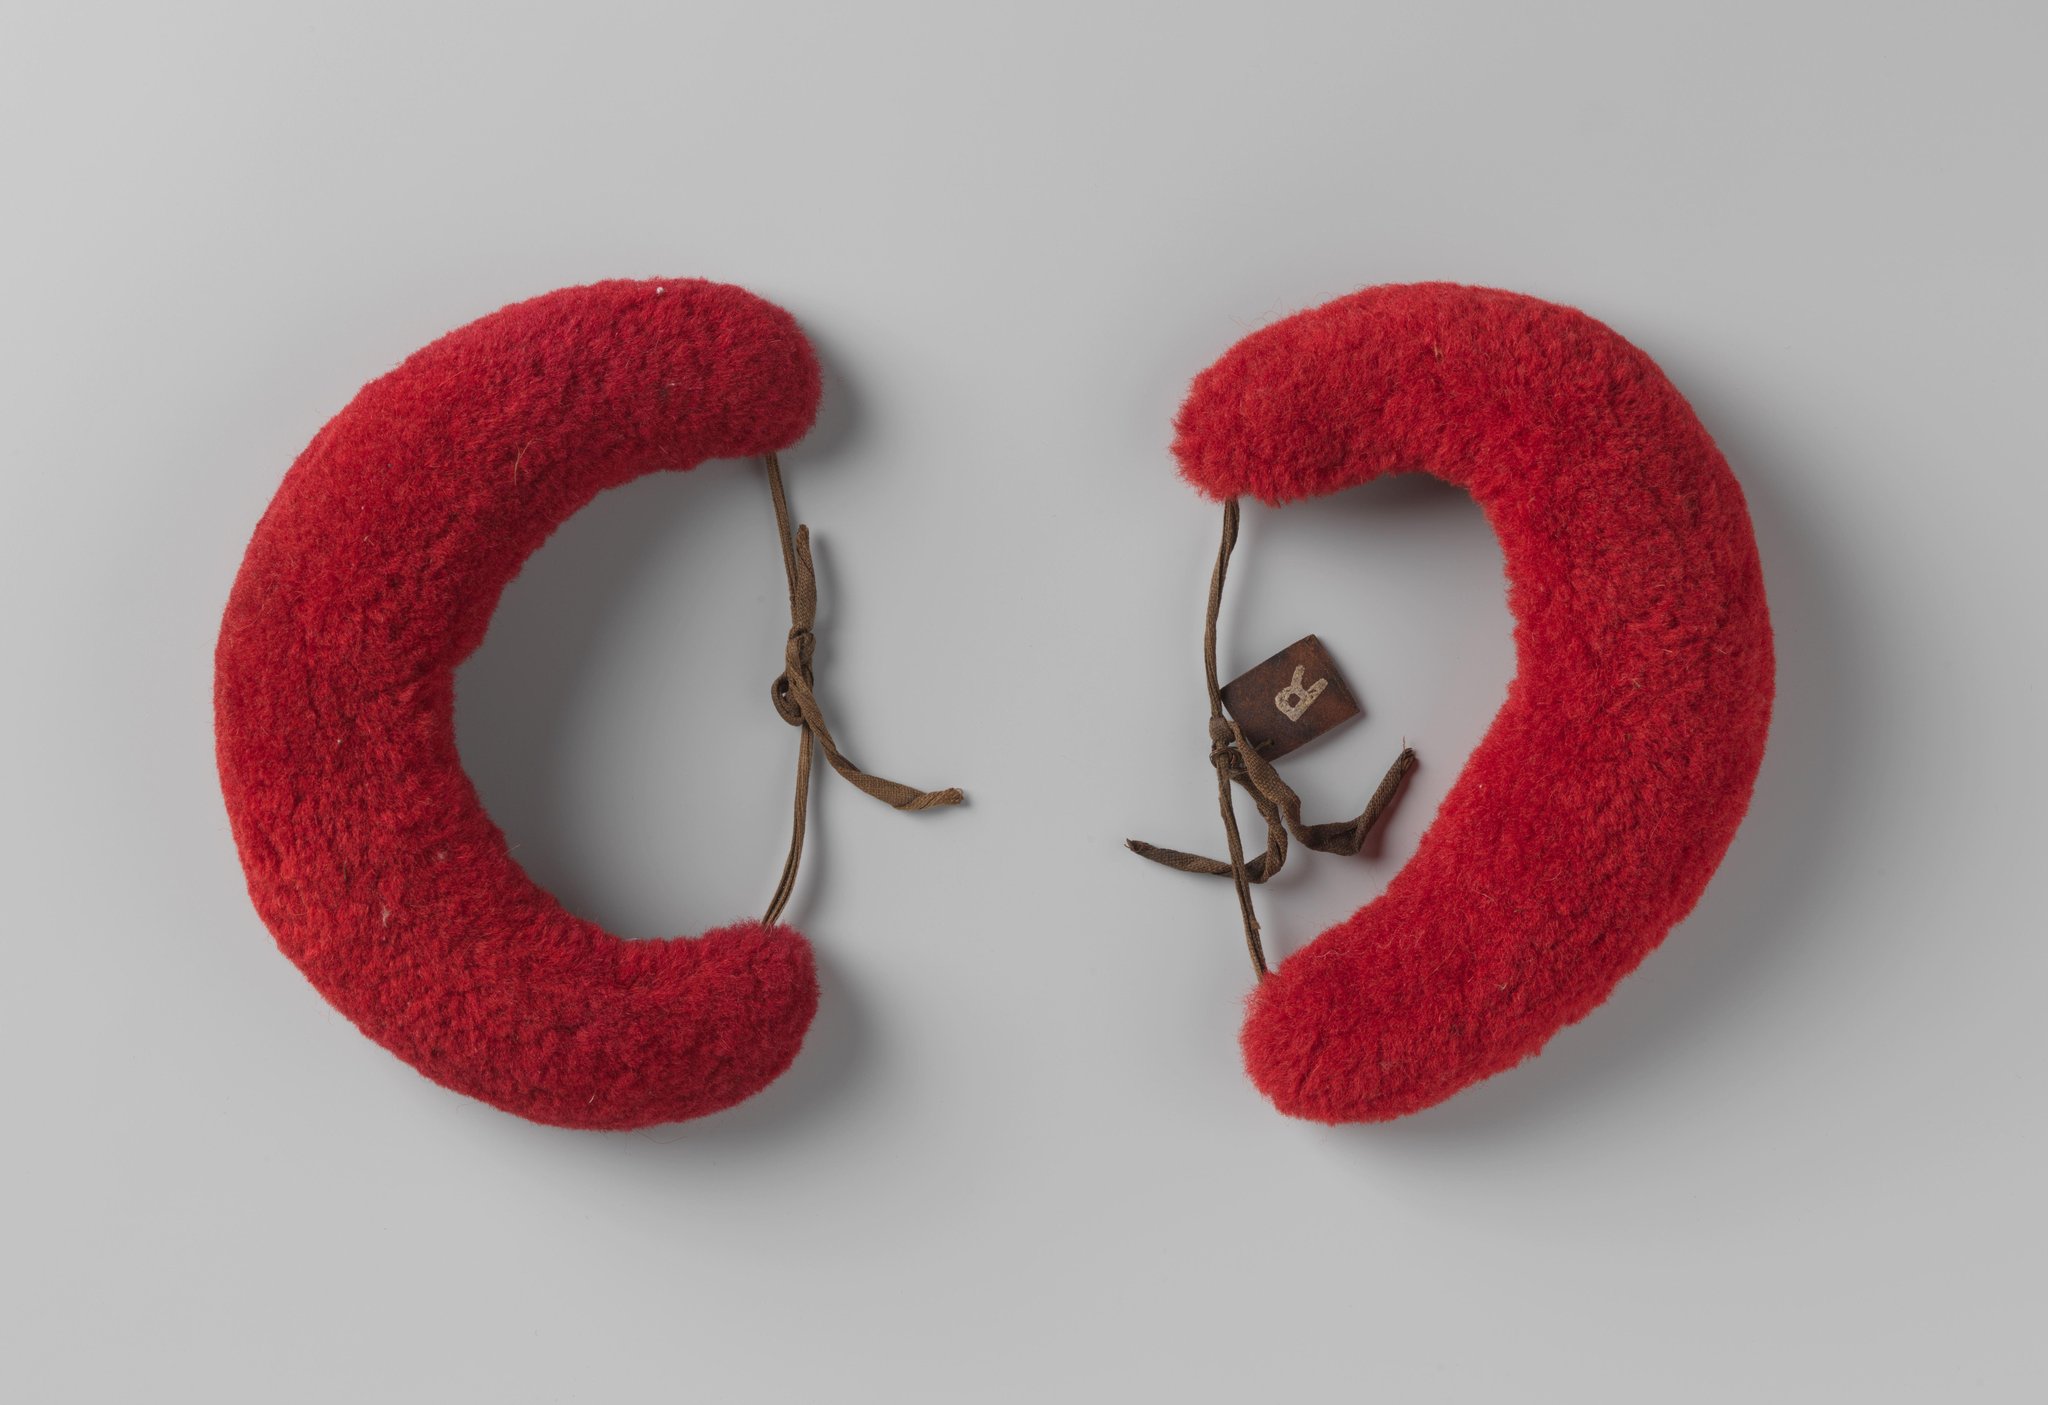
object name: wing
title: Wings voor schutters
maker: Anonymous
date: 1840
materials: textile, hair, wool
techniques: stitching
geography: netherlands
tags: netherlands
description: Schouderbedekking, halfrond van vorm, van rode wol met grijze lakense voering. Aan de veters ter bevestiging aan de uniformjas een leren label met letter: R.